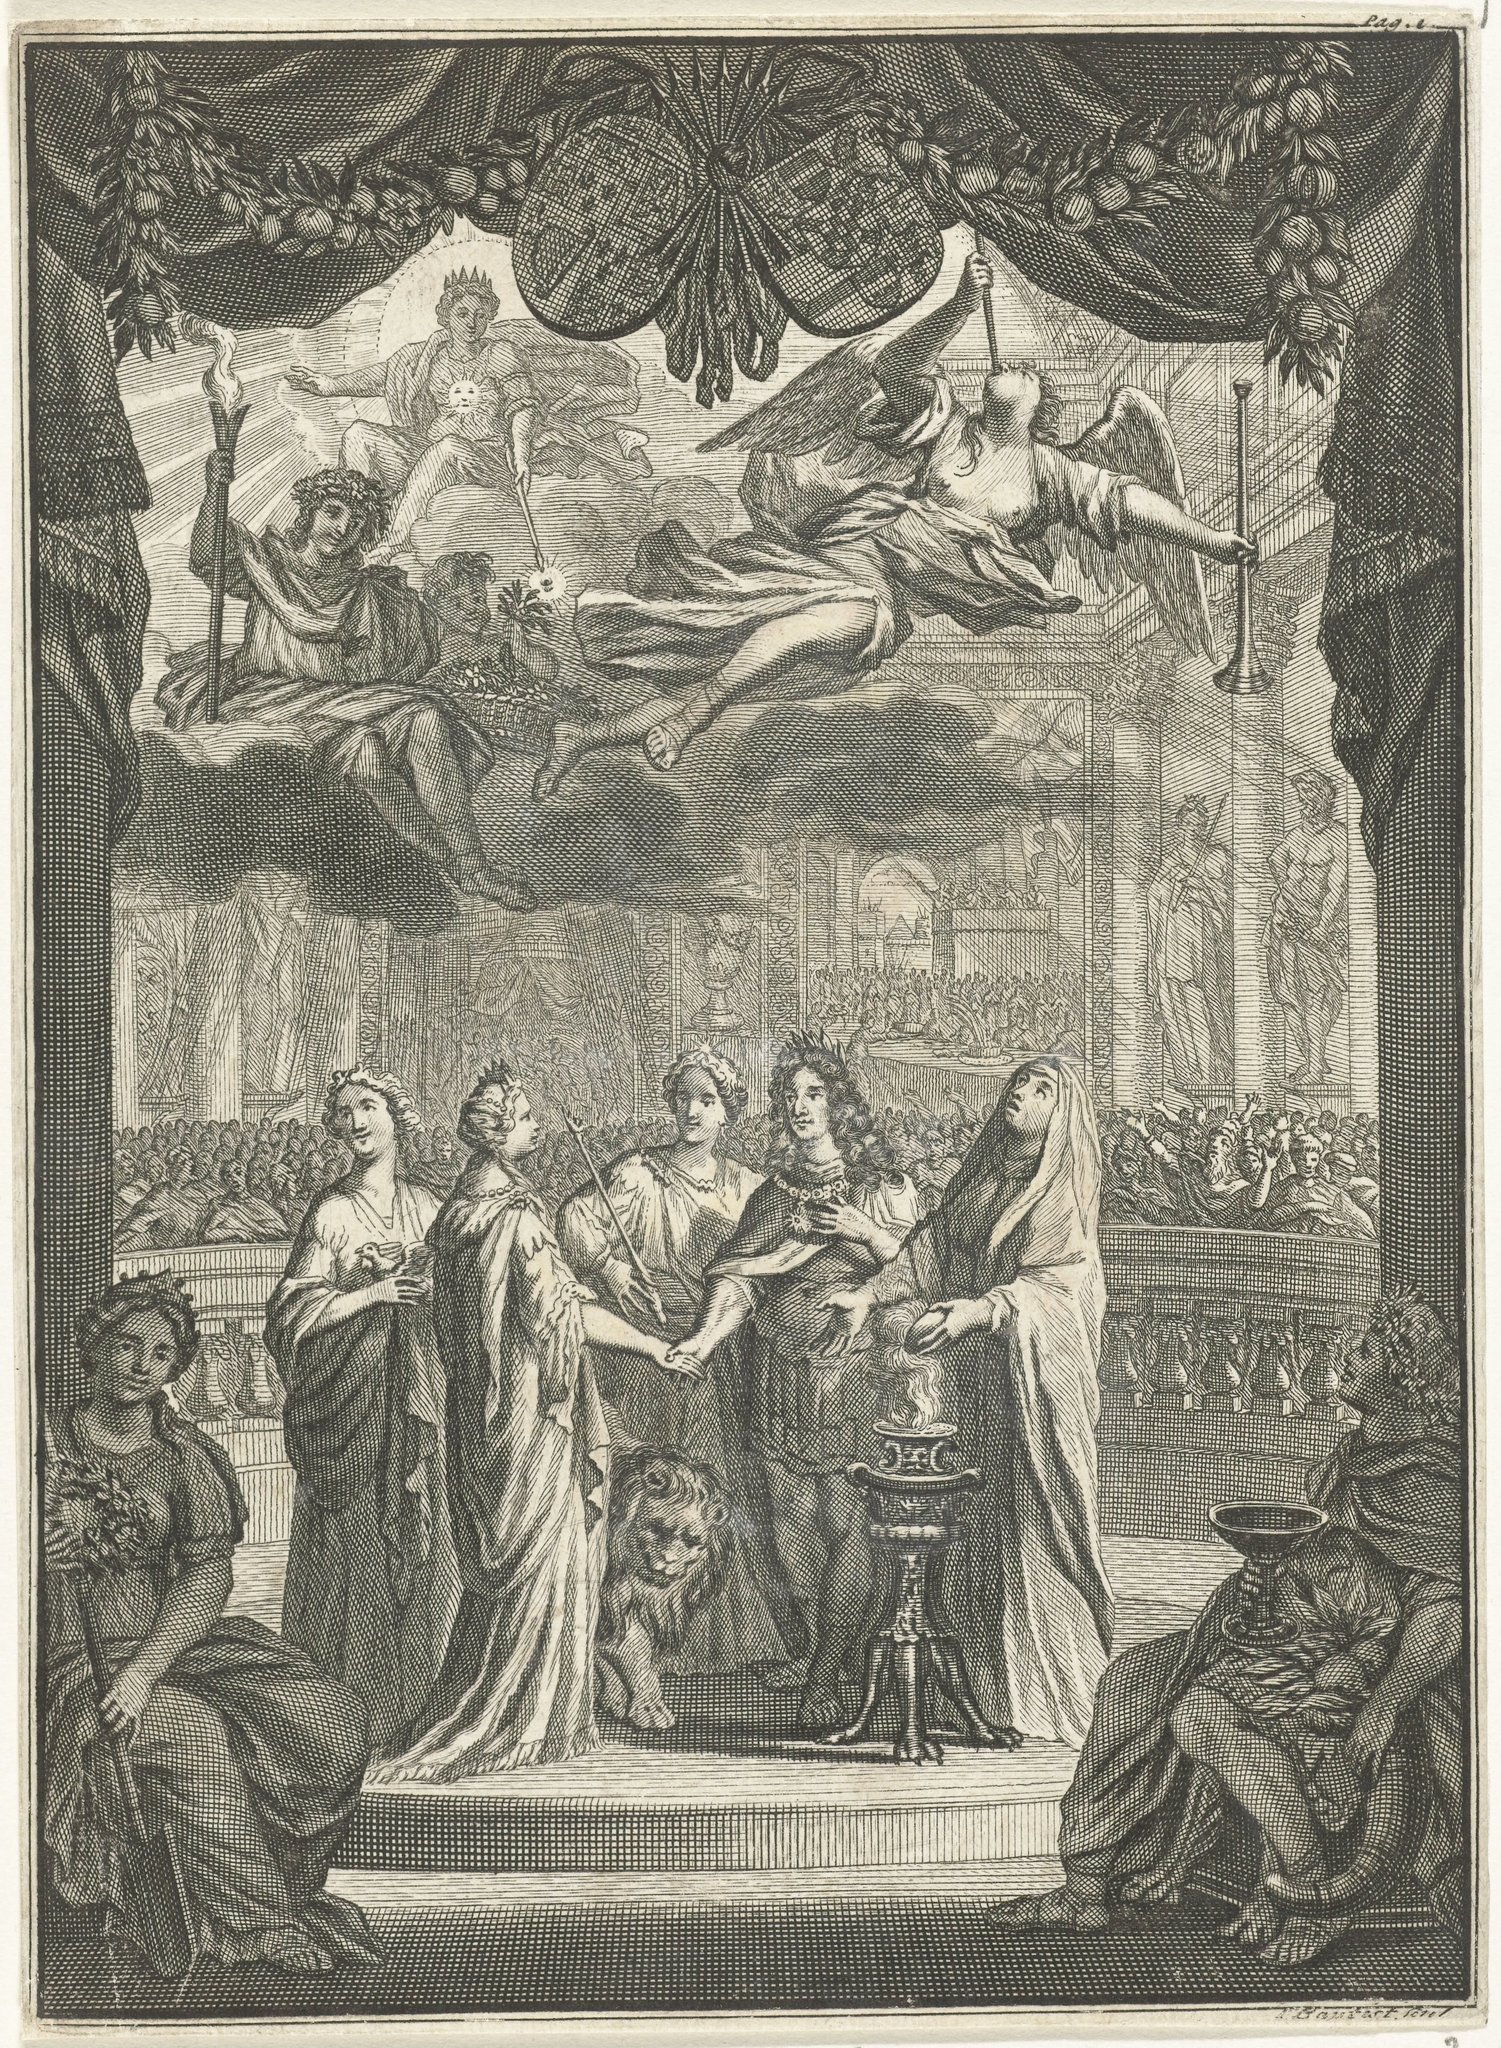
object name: print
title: Allegorische voorstelling van het huwelijk van Willem III met Maria Stuart, 1677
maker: jacobus baptist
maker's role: print maker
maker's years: 1658-1704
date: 1696-1700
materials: paper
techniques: engraving, etching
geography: amsterdam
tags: the hague, william iii (prince of orange and king of england, scotland, and ireland), london, maria ii stuart (koningin van engeland, schotland en ierland), marriage, married couple, 'matrimonium'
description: Allegorische voorstelling van het huwelijk van Willem III met Maria Stuart, 4 november 1677. Willem III en Maria Stuart staan in een grote hal en houden elkaars hand vast. Drie vrouwen en een leeuw staan om hen heen. Op de achtergrond wacht achter een balustrade het volk. Goden kijken vanuit de hemel naar de scène, een engel blaast op een bazuin.